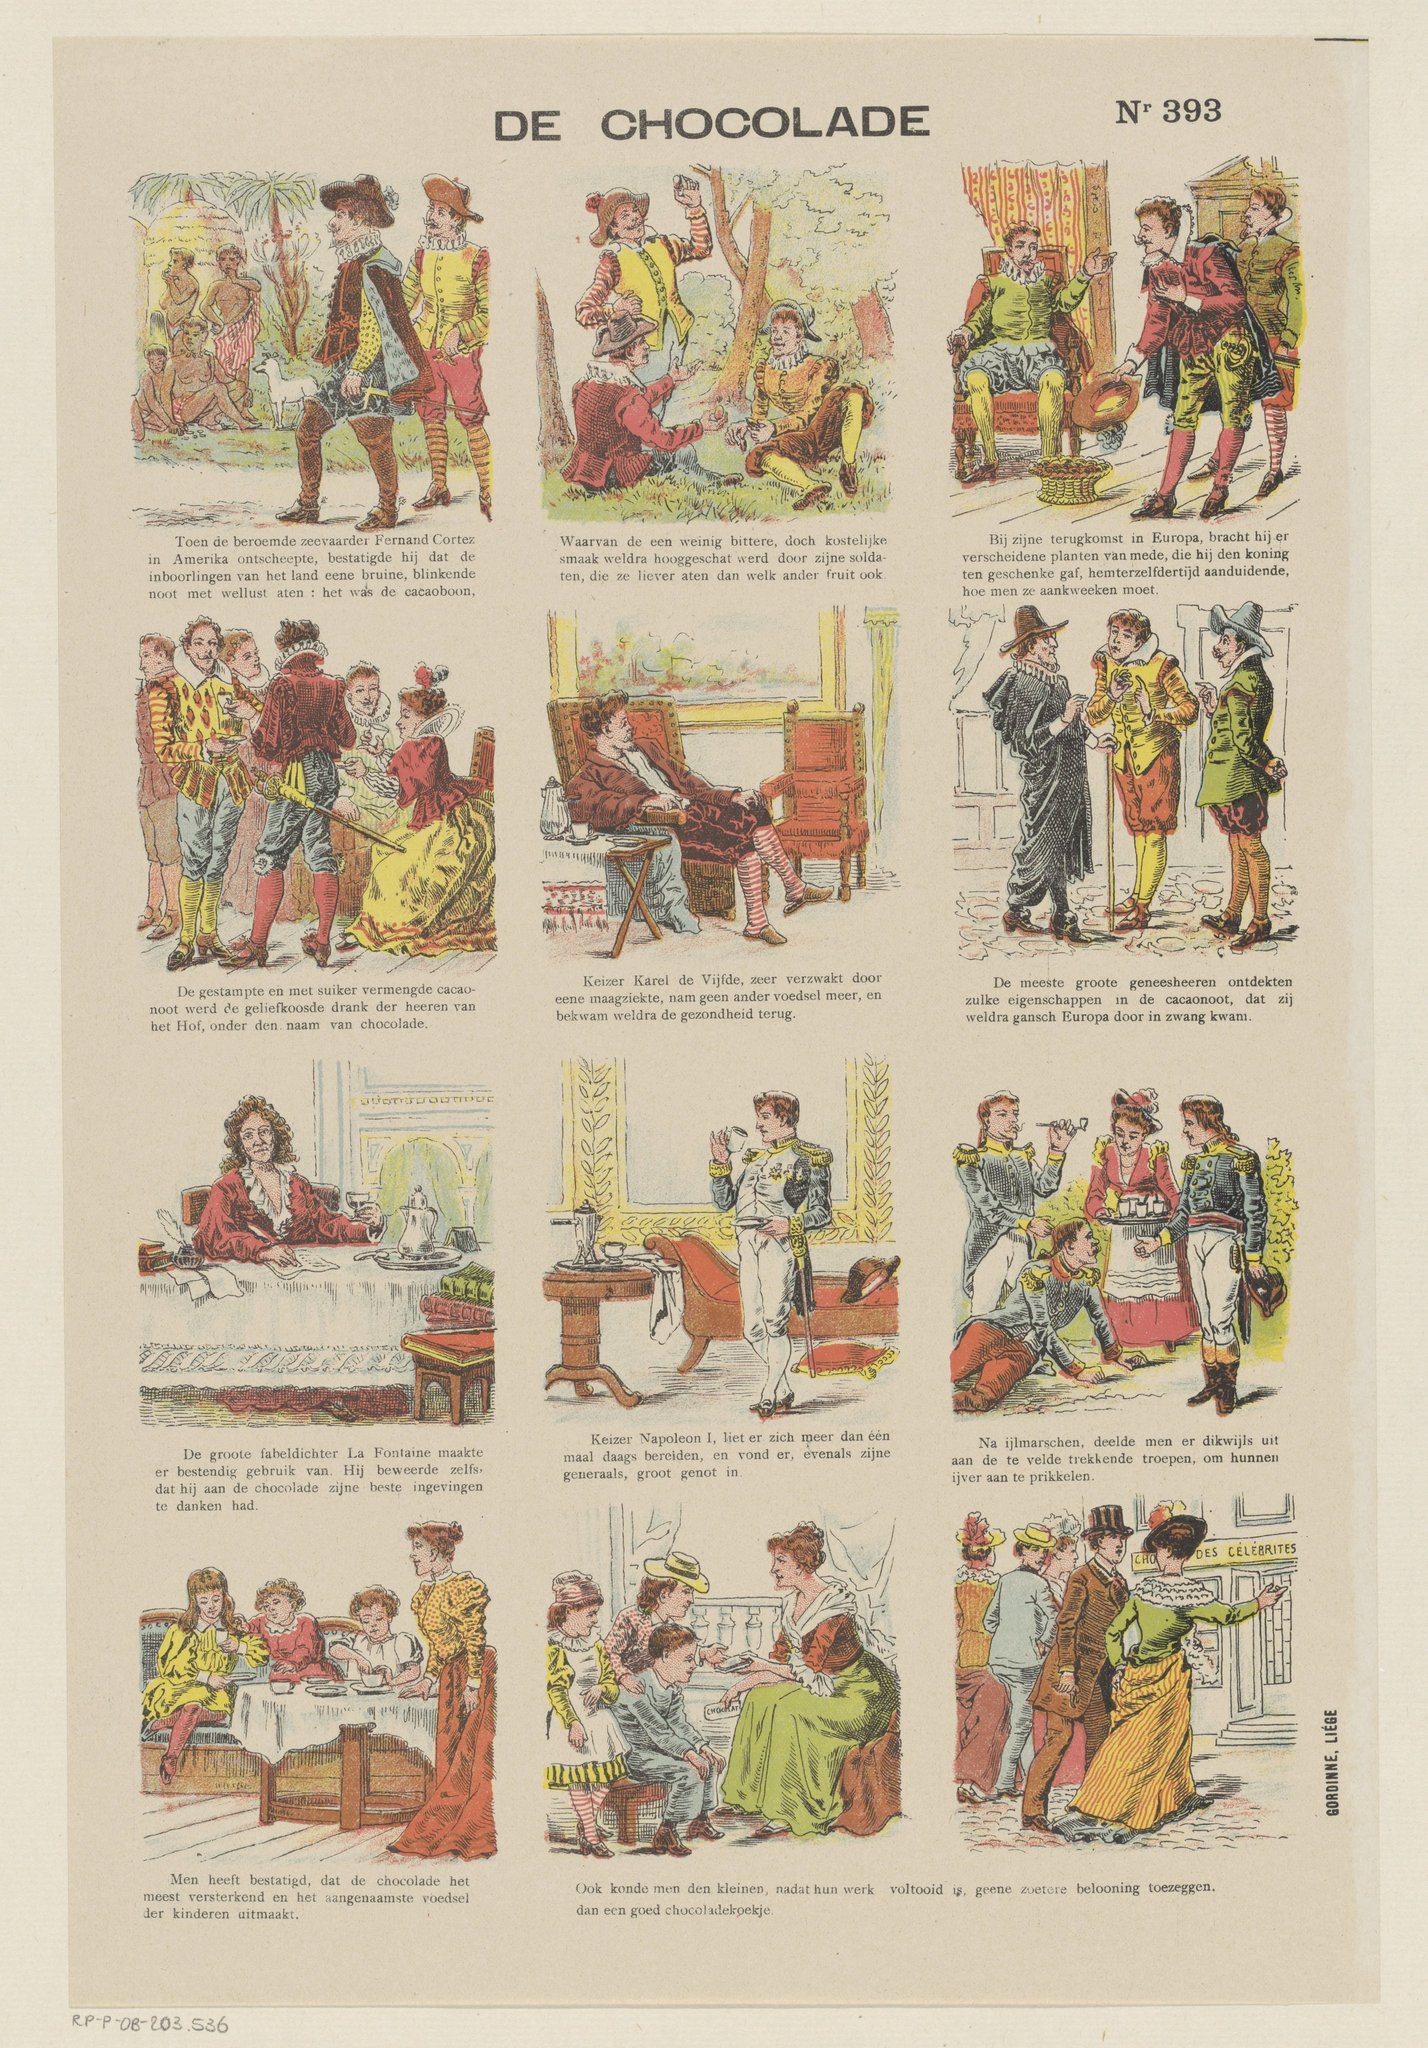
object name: popular print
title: De chocolade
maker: Anonymous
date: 1894-1959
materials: paper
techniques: lithograph, letterpress printing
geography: liège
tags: chocolate, cocoa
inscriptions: collector's mark: Lugt 2760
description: Blad met 12 voorstellingen over de ontdekking van cacao in Amerika, en de verspreiding van chocolademelk in Europa. Onder elke afbeelding een onderschrift. Genummerd rechtsboven: No 393.